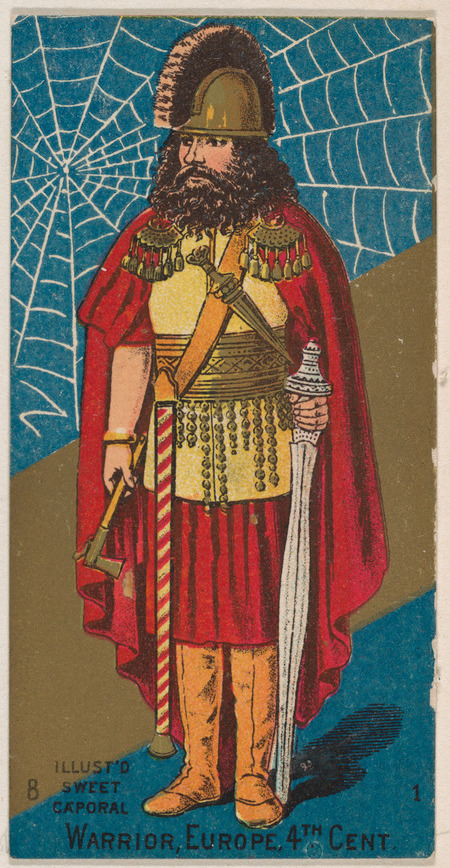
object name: print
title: Warrior, Europe, 4th Century, from the Military Series (N224) issued by Kinney Tobacco Company to promote Sweet Caporal Cigarettes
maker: kinney brothers tobacco company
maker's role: publisher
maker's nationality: american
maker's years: 1869-2011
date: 1888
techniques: color lithograph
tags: military,men